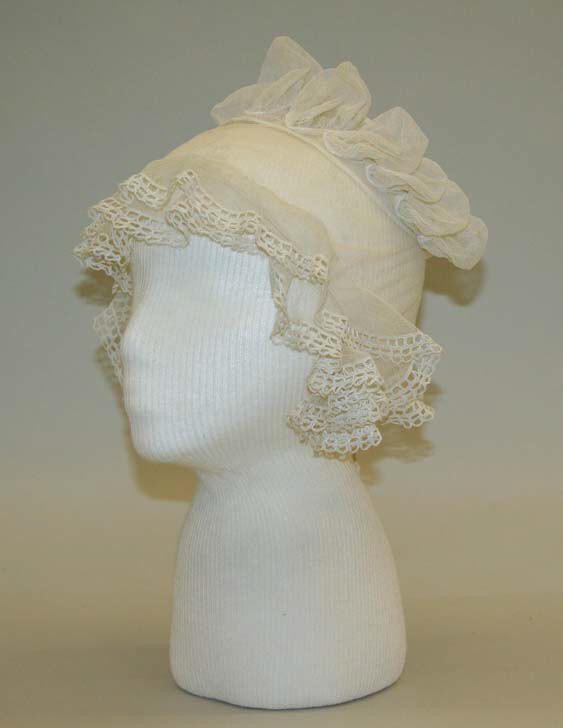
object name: morning cap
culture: british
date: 1805-1810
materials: cotton